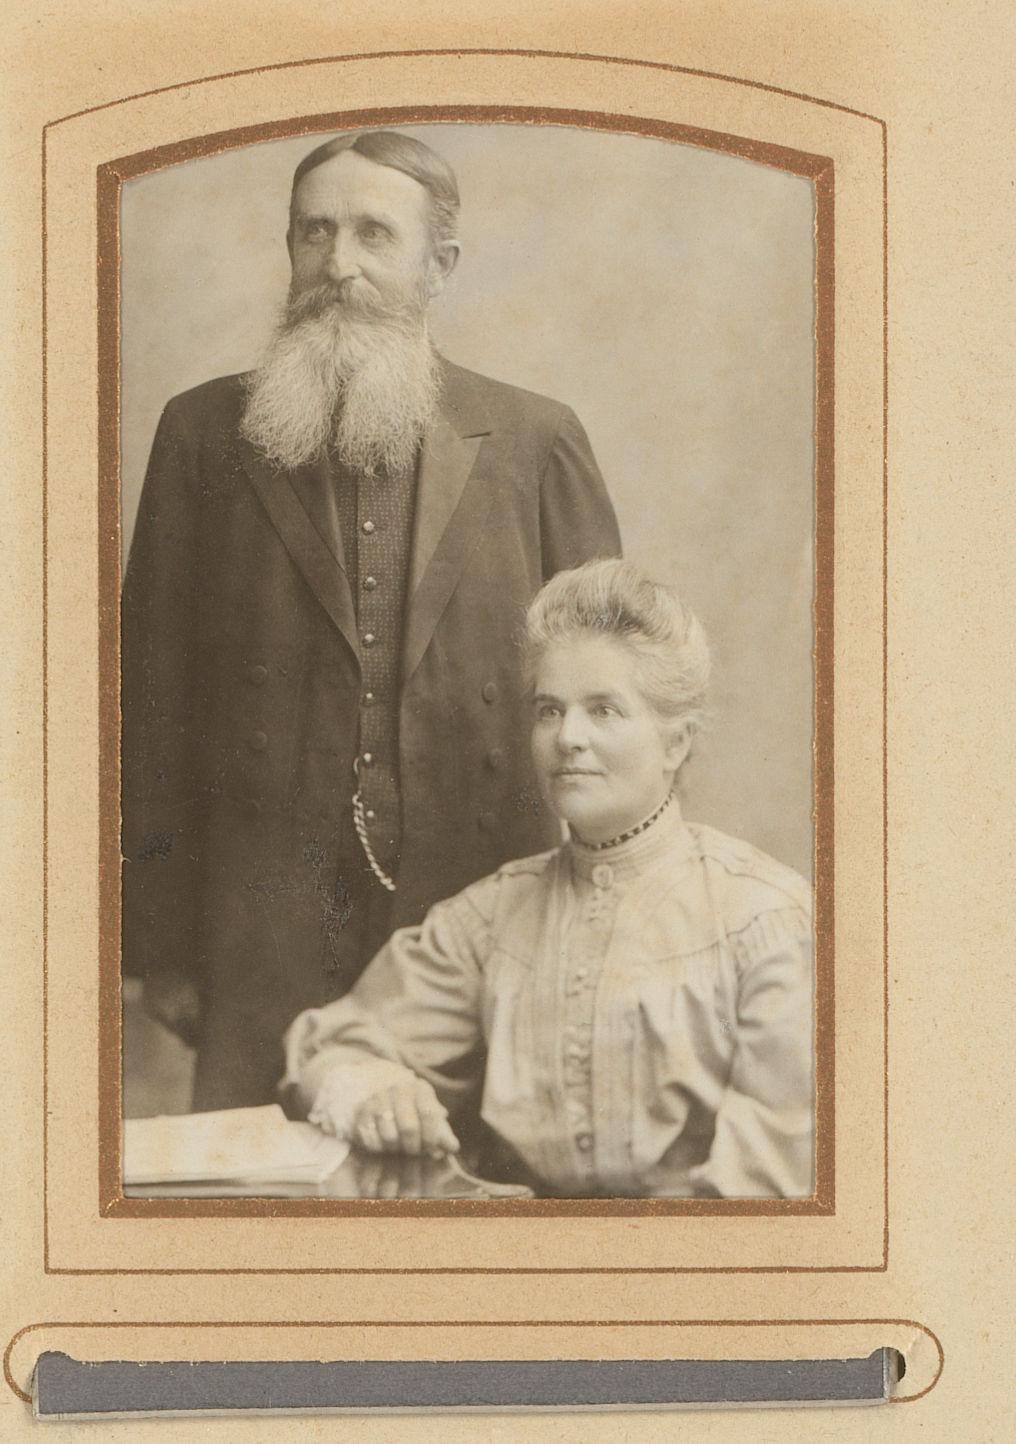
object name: album leaf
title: Portret van man en vrouw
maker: f. vachoux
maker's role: fotograaf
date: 1890-1910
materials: cardboard, photographic support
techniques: collodion silver print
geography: montreux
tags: historical persons - bb - woman, historical persons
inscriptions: inscription: ‘F. Vachoux/ Montreux’